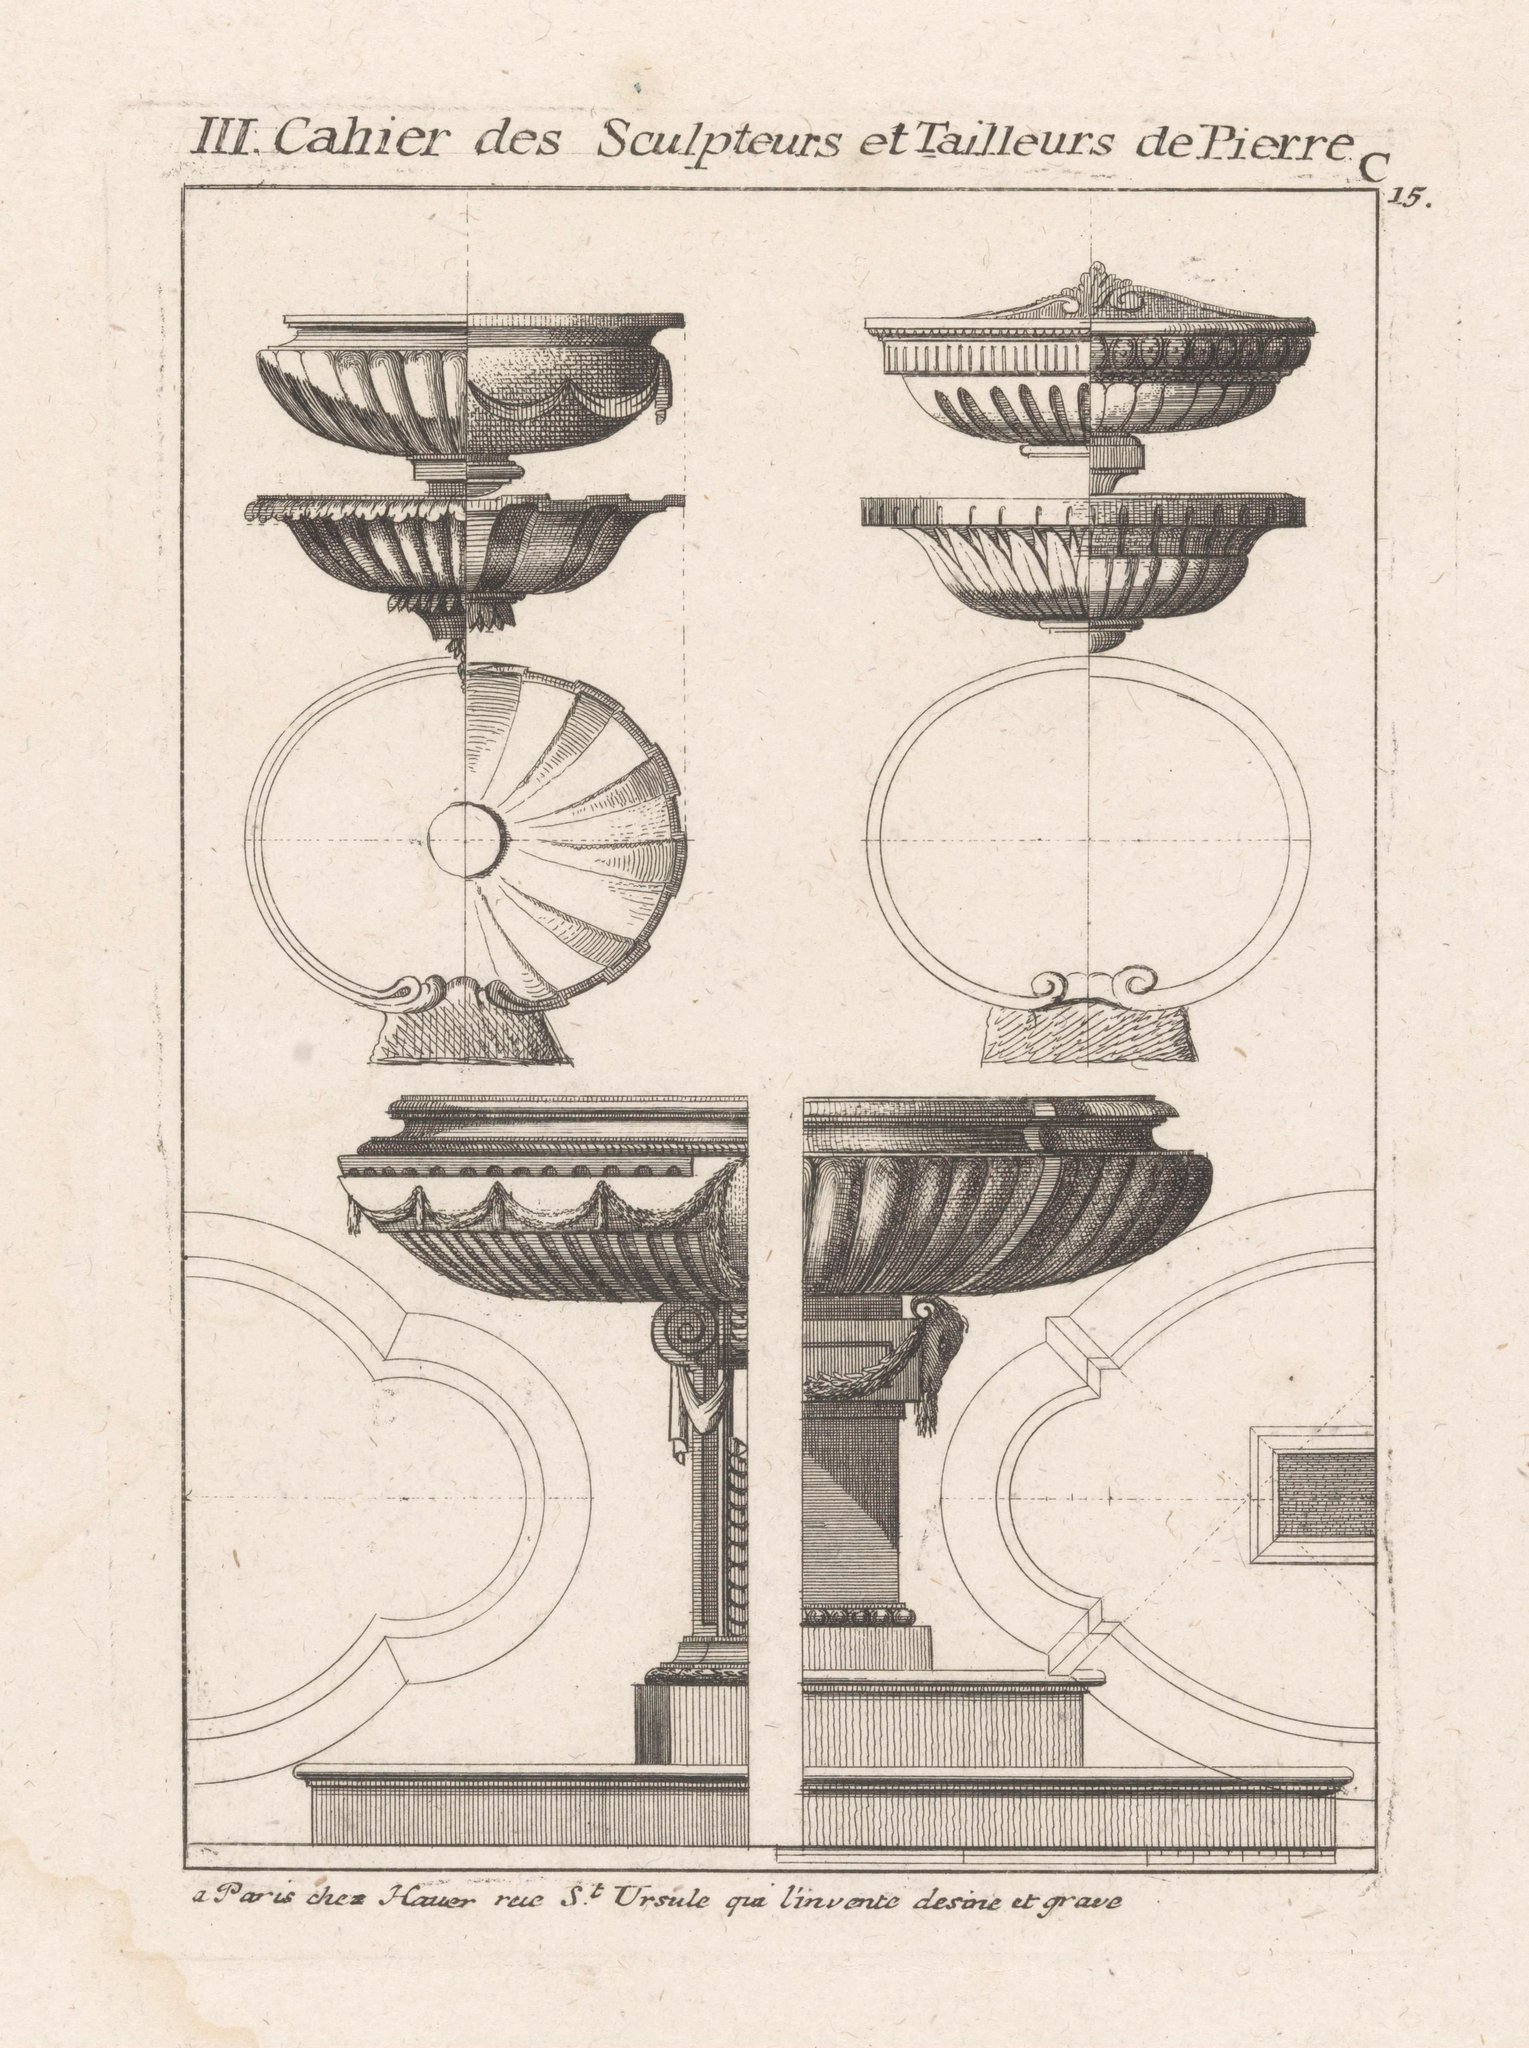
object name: ornament print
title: Zes doopvonten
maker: johann thomas hauer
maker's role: print maker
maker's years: 1748-1820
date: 1781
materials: paper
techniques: engraving, etching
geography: paris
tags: baptismal font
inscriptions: collector's mark: Lugt 2228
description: Plattegronden en ontwerpen van zes doopvonten.